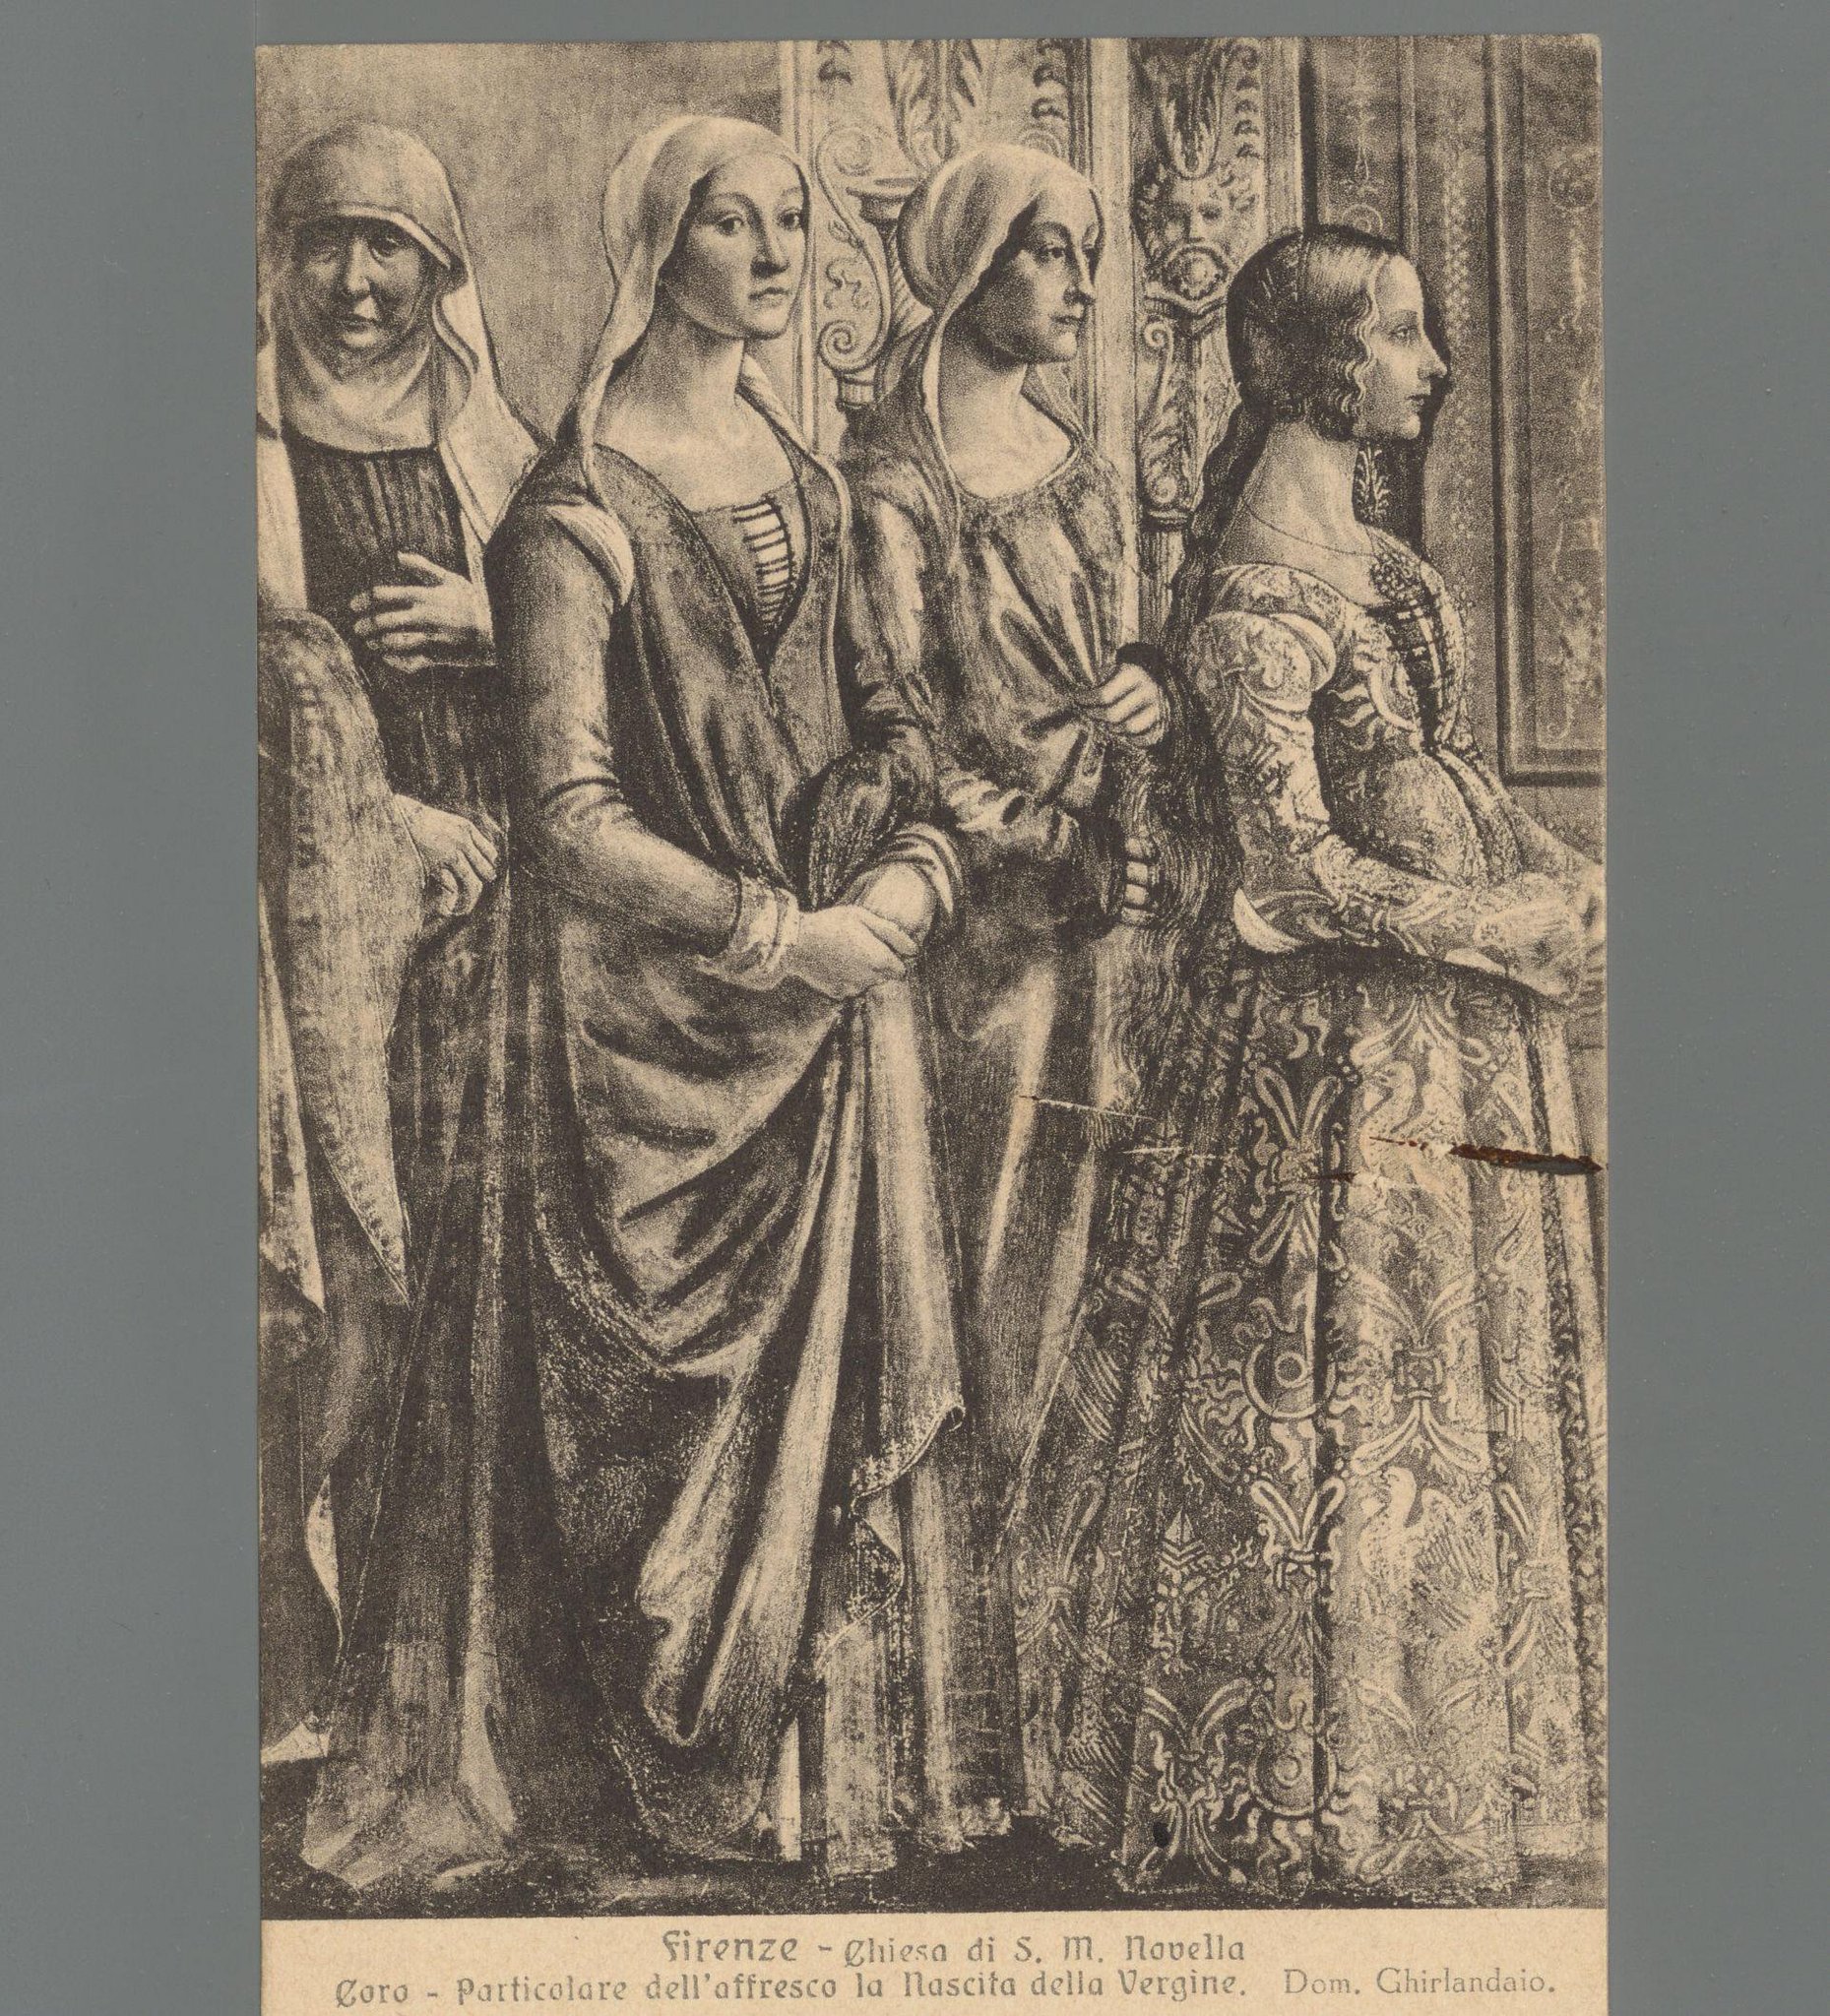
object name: ansichtkaart, prentbriefkaart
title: Firenze - Chiesa di S. M. Novella. Coro - Particolare dell'affresco la Nascita della Vergine. Dom. Ghirlandaio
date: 1906-1930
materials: cardboard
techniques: photograph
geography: florence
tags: church (exterior), gate, entrance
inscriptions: collector's mark: ‘AFE v S’